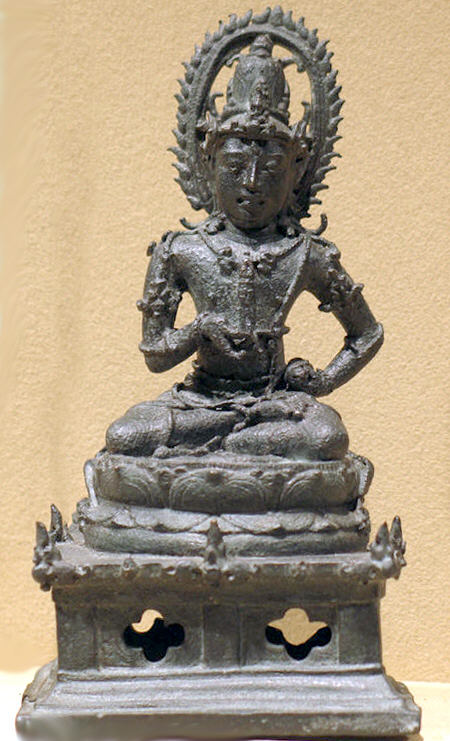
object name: figure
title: Seated Bodhisattva Vajrasattva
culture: indonesian, javanese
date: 967-1033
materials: bronze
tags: buddhism,bodhisattvas